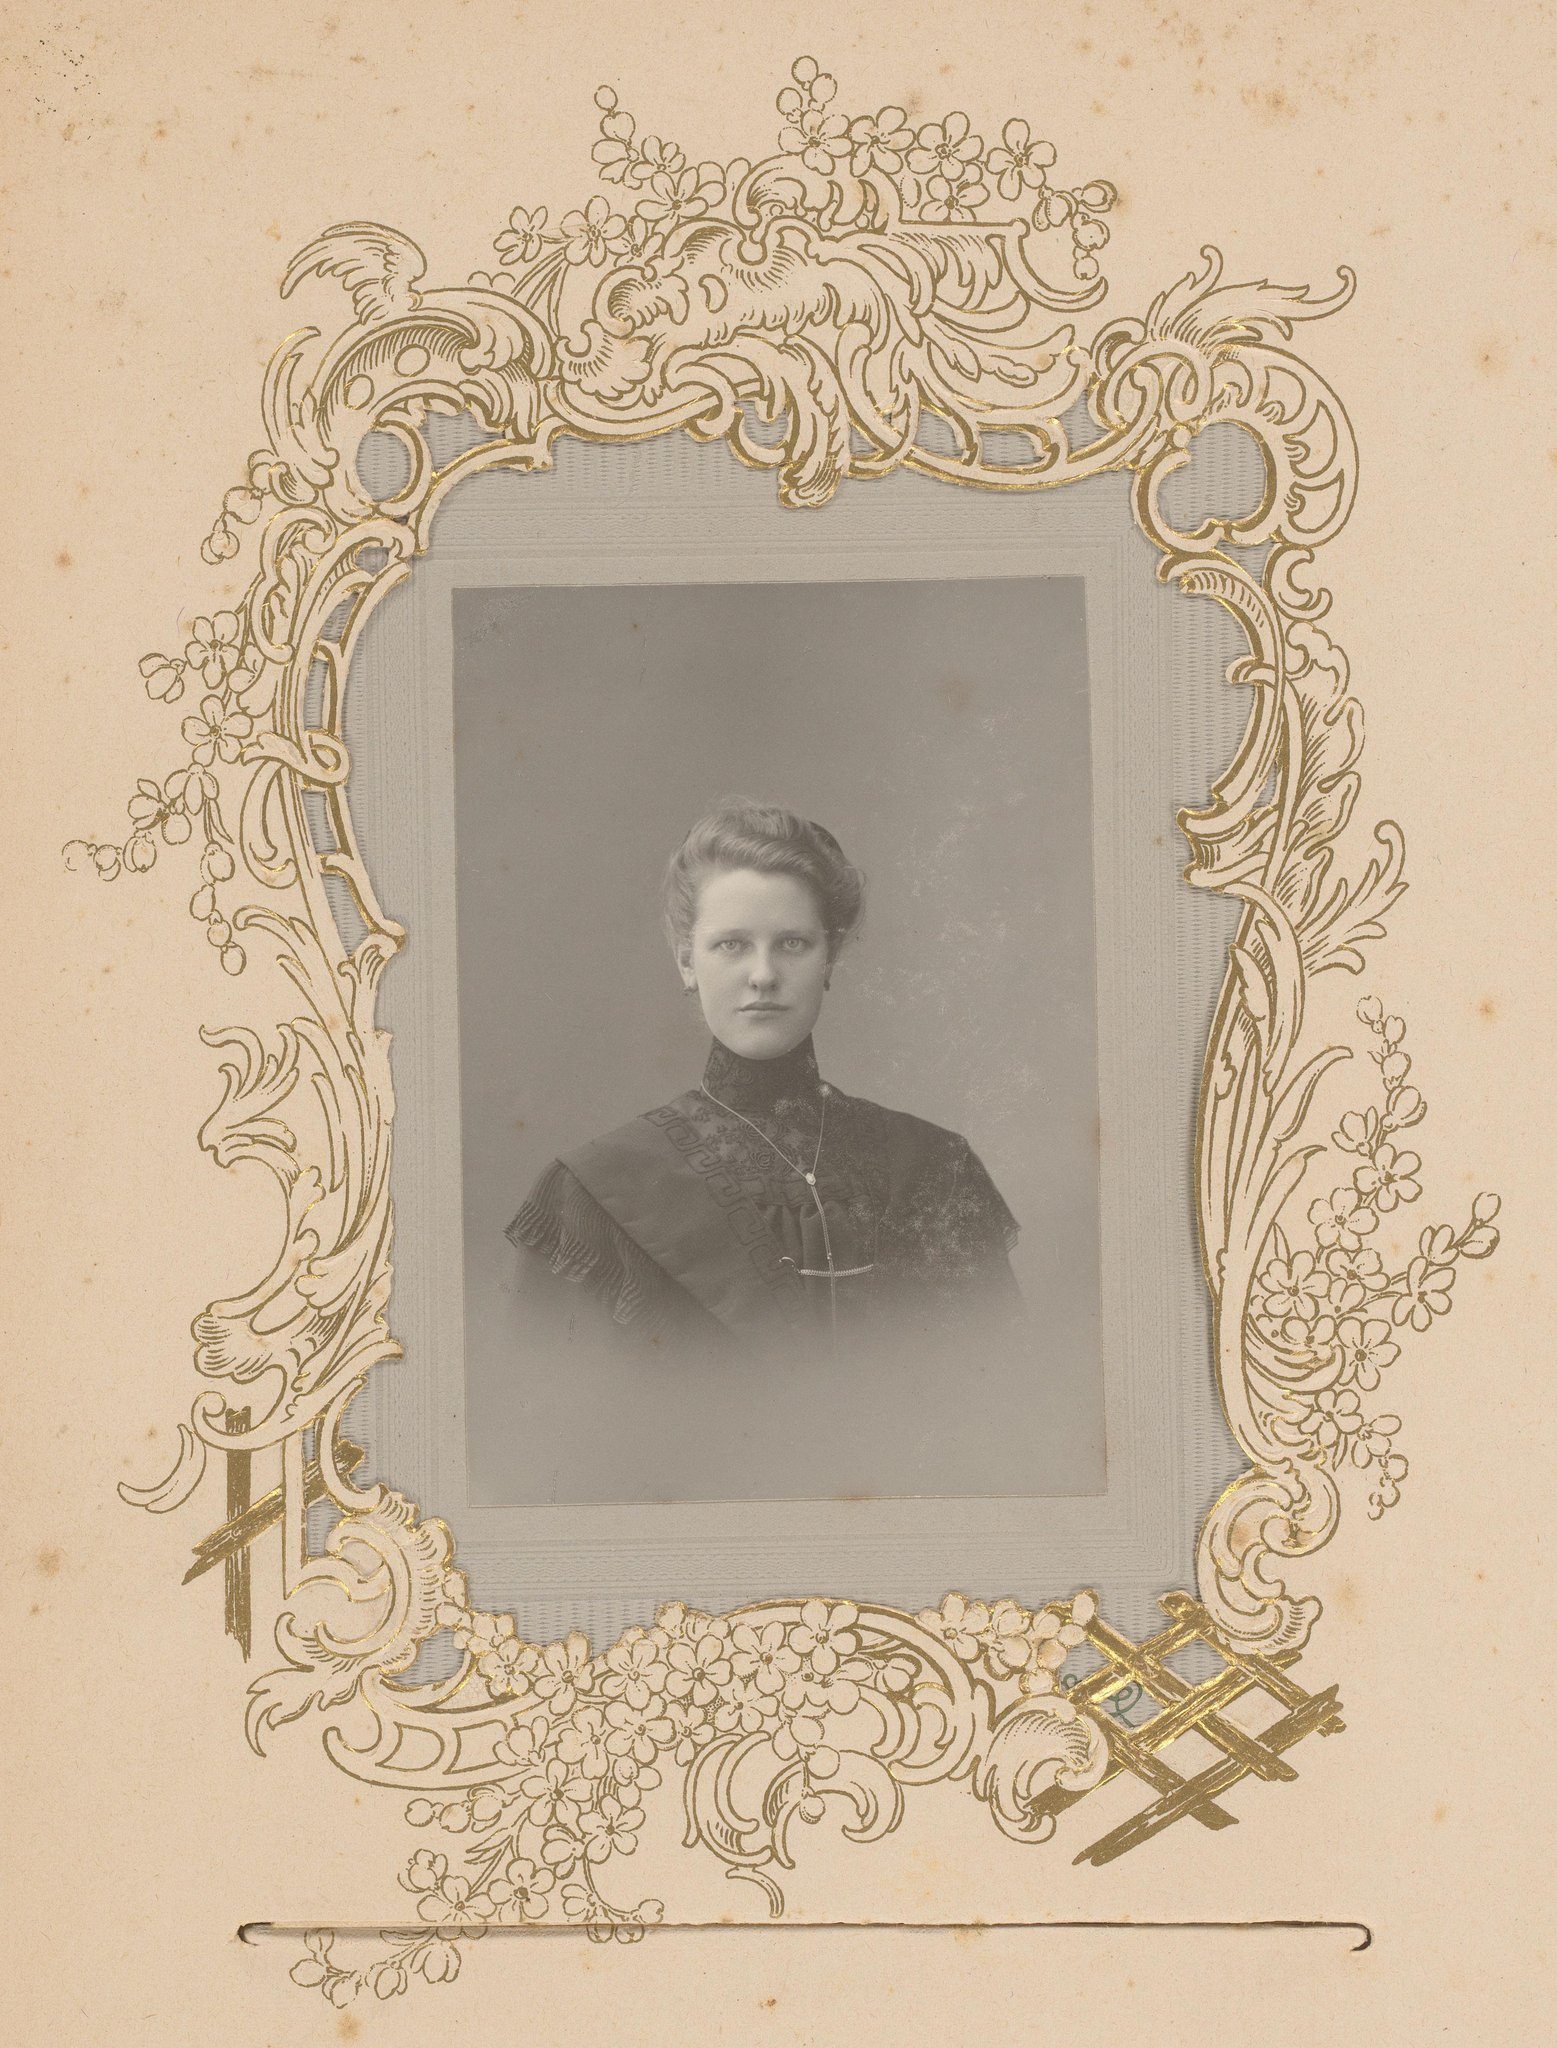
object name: photograph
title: Portret van een staande jonge vrouw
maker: Anonymous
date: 1880-1910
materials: cardboard, photographic support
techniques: albumen print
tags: historical persons - bb - woman, standing figure - aa - female human figure